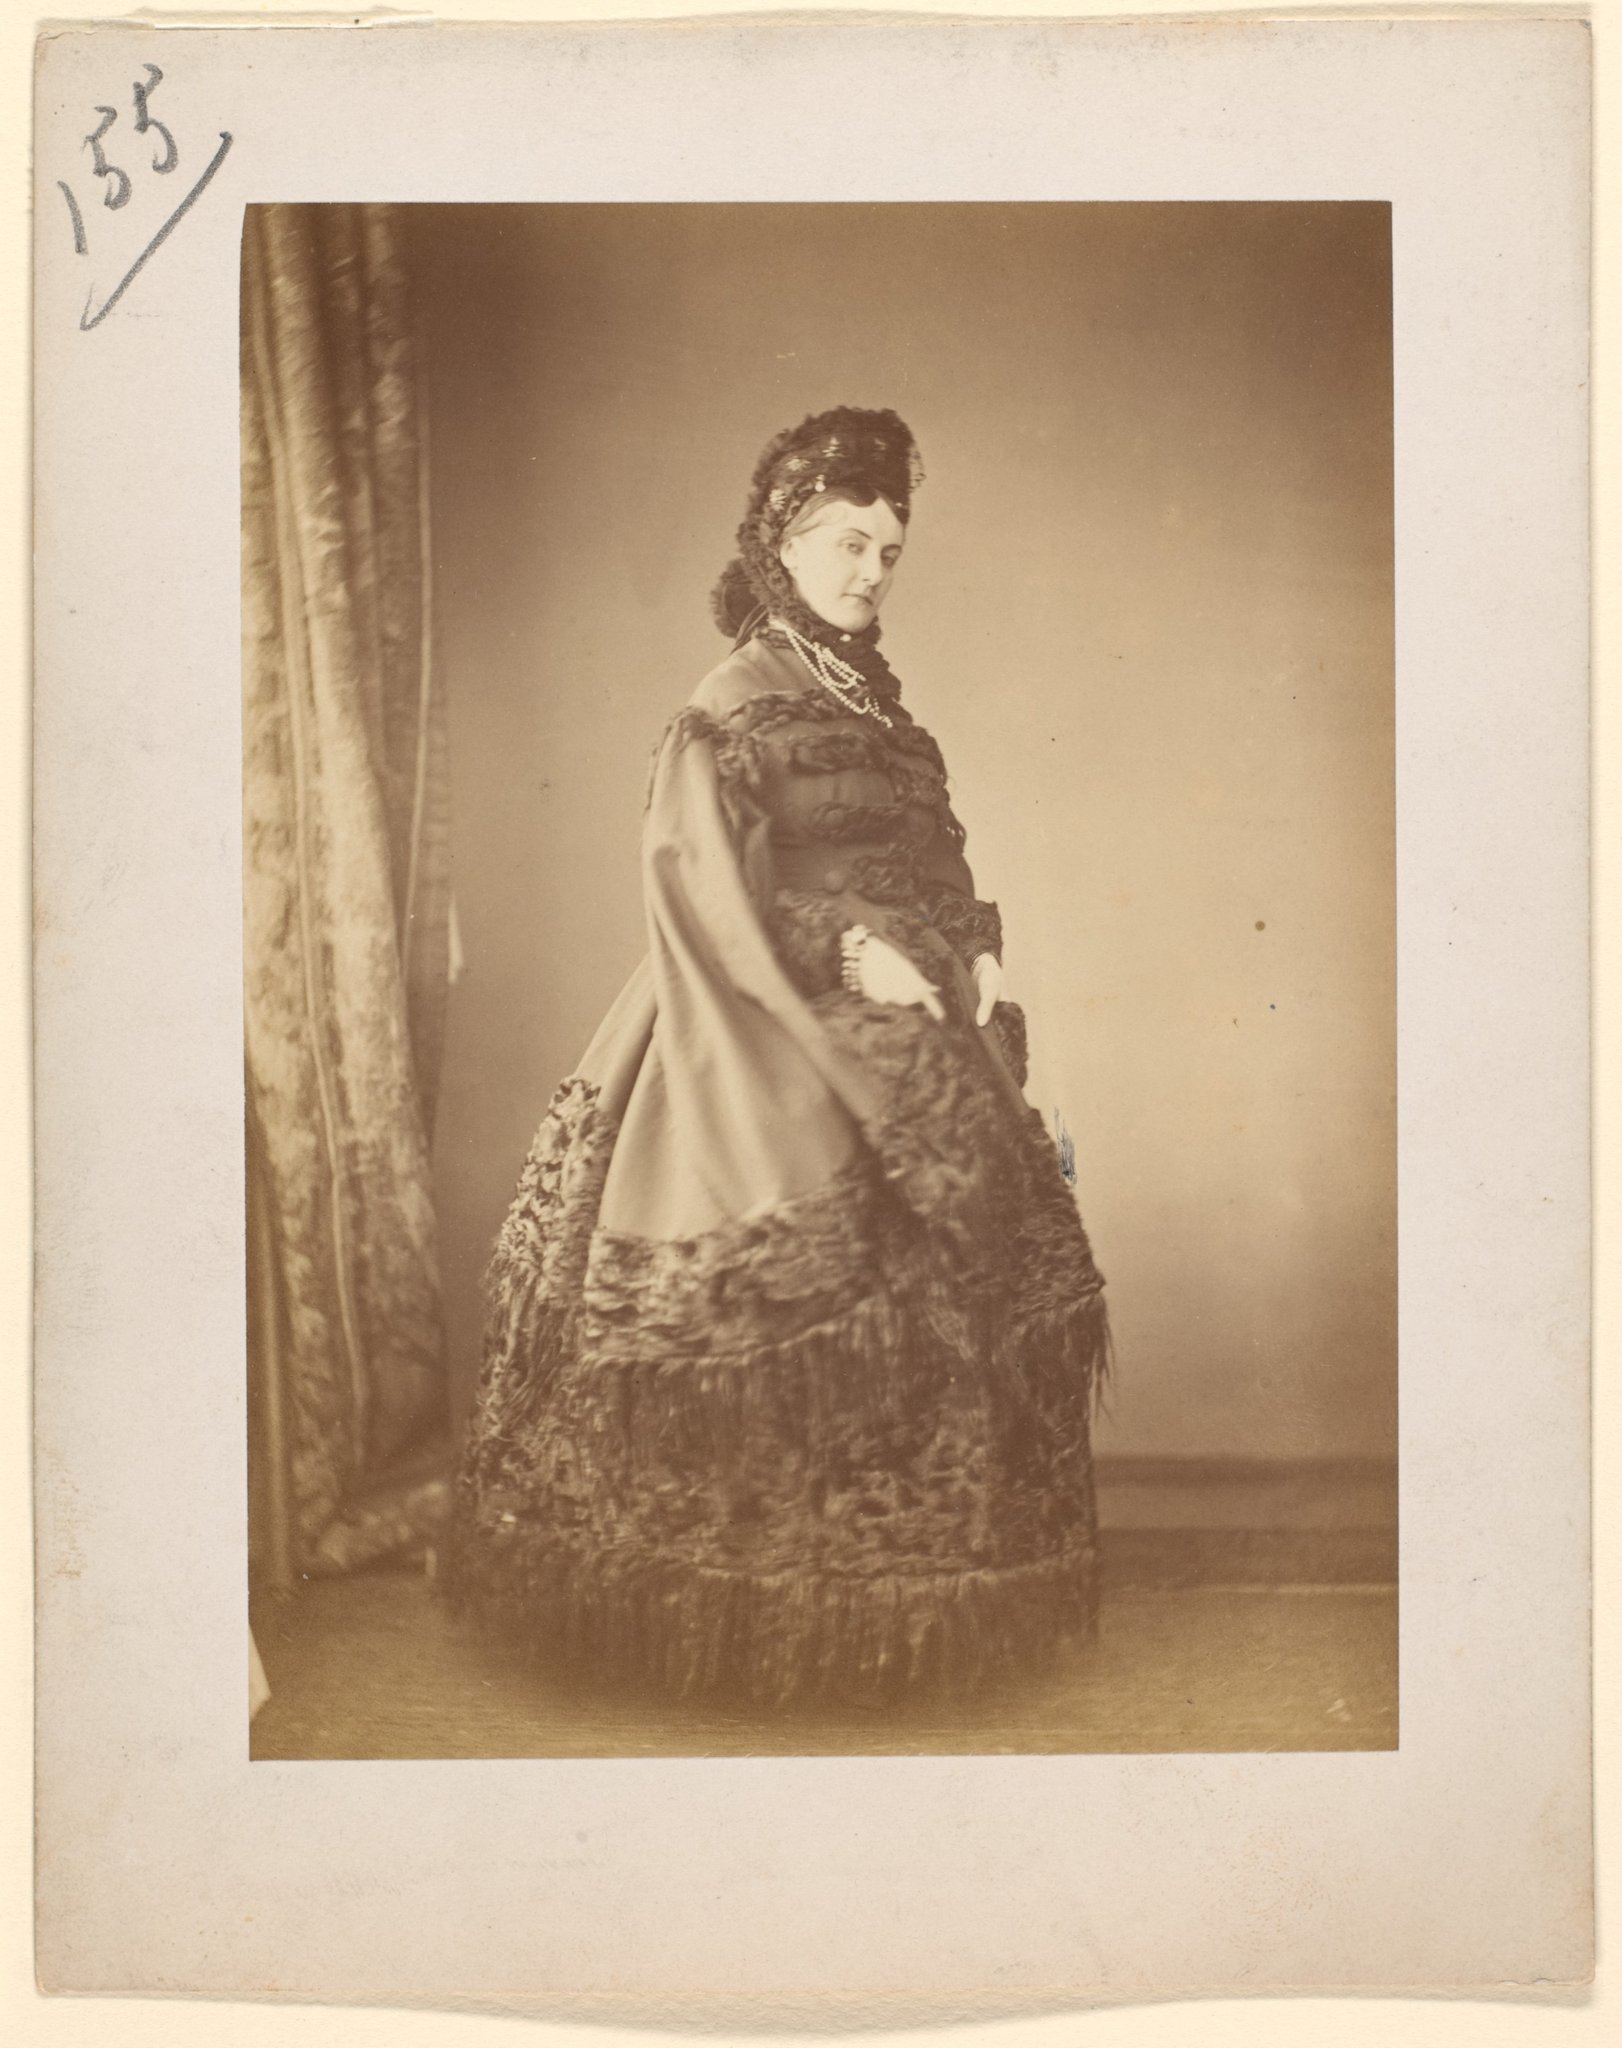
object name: photograph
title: Le Caracul (L'Astrakhan)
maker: pierre-louis pierson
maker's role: artist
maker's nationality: french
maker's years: 1822-1913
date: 1860-1869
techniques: albumen silver print, glass negative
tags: portraits,women